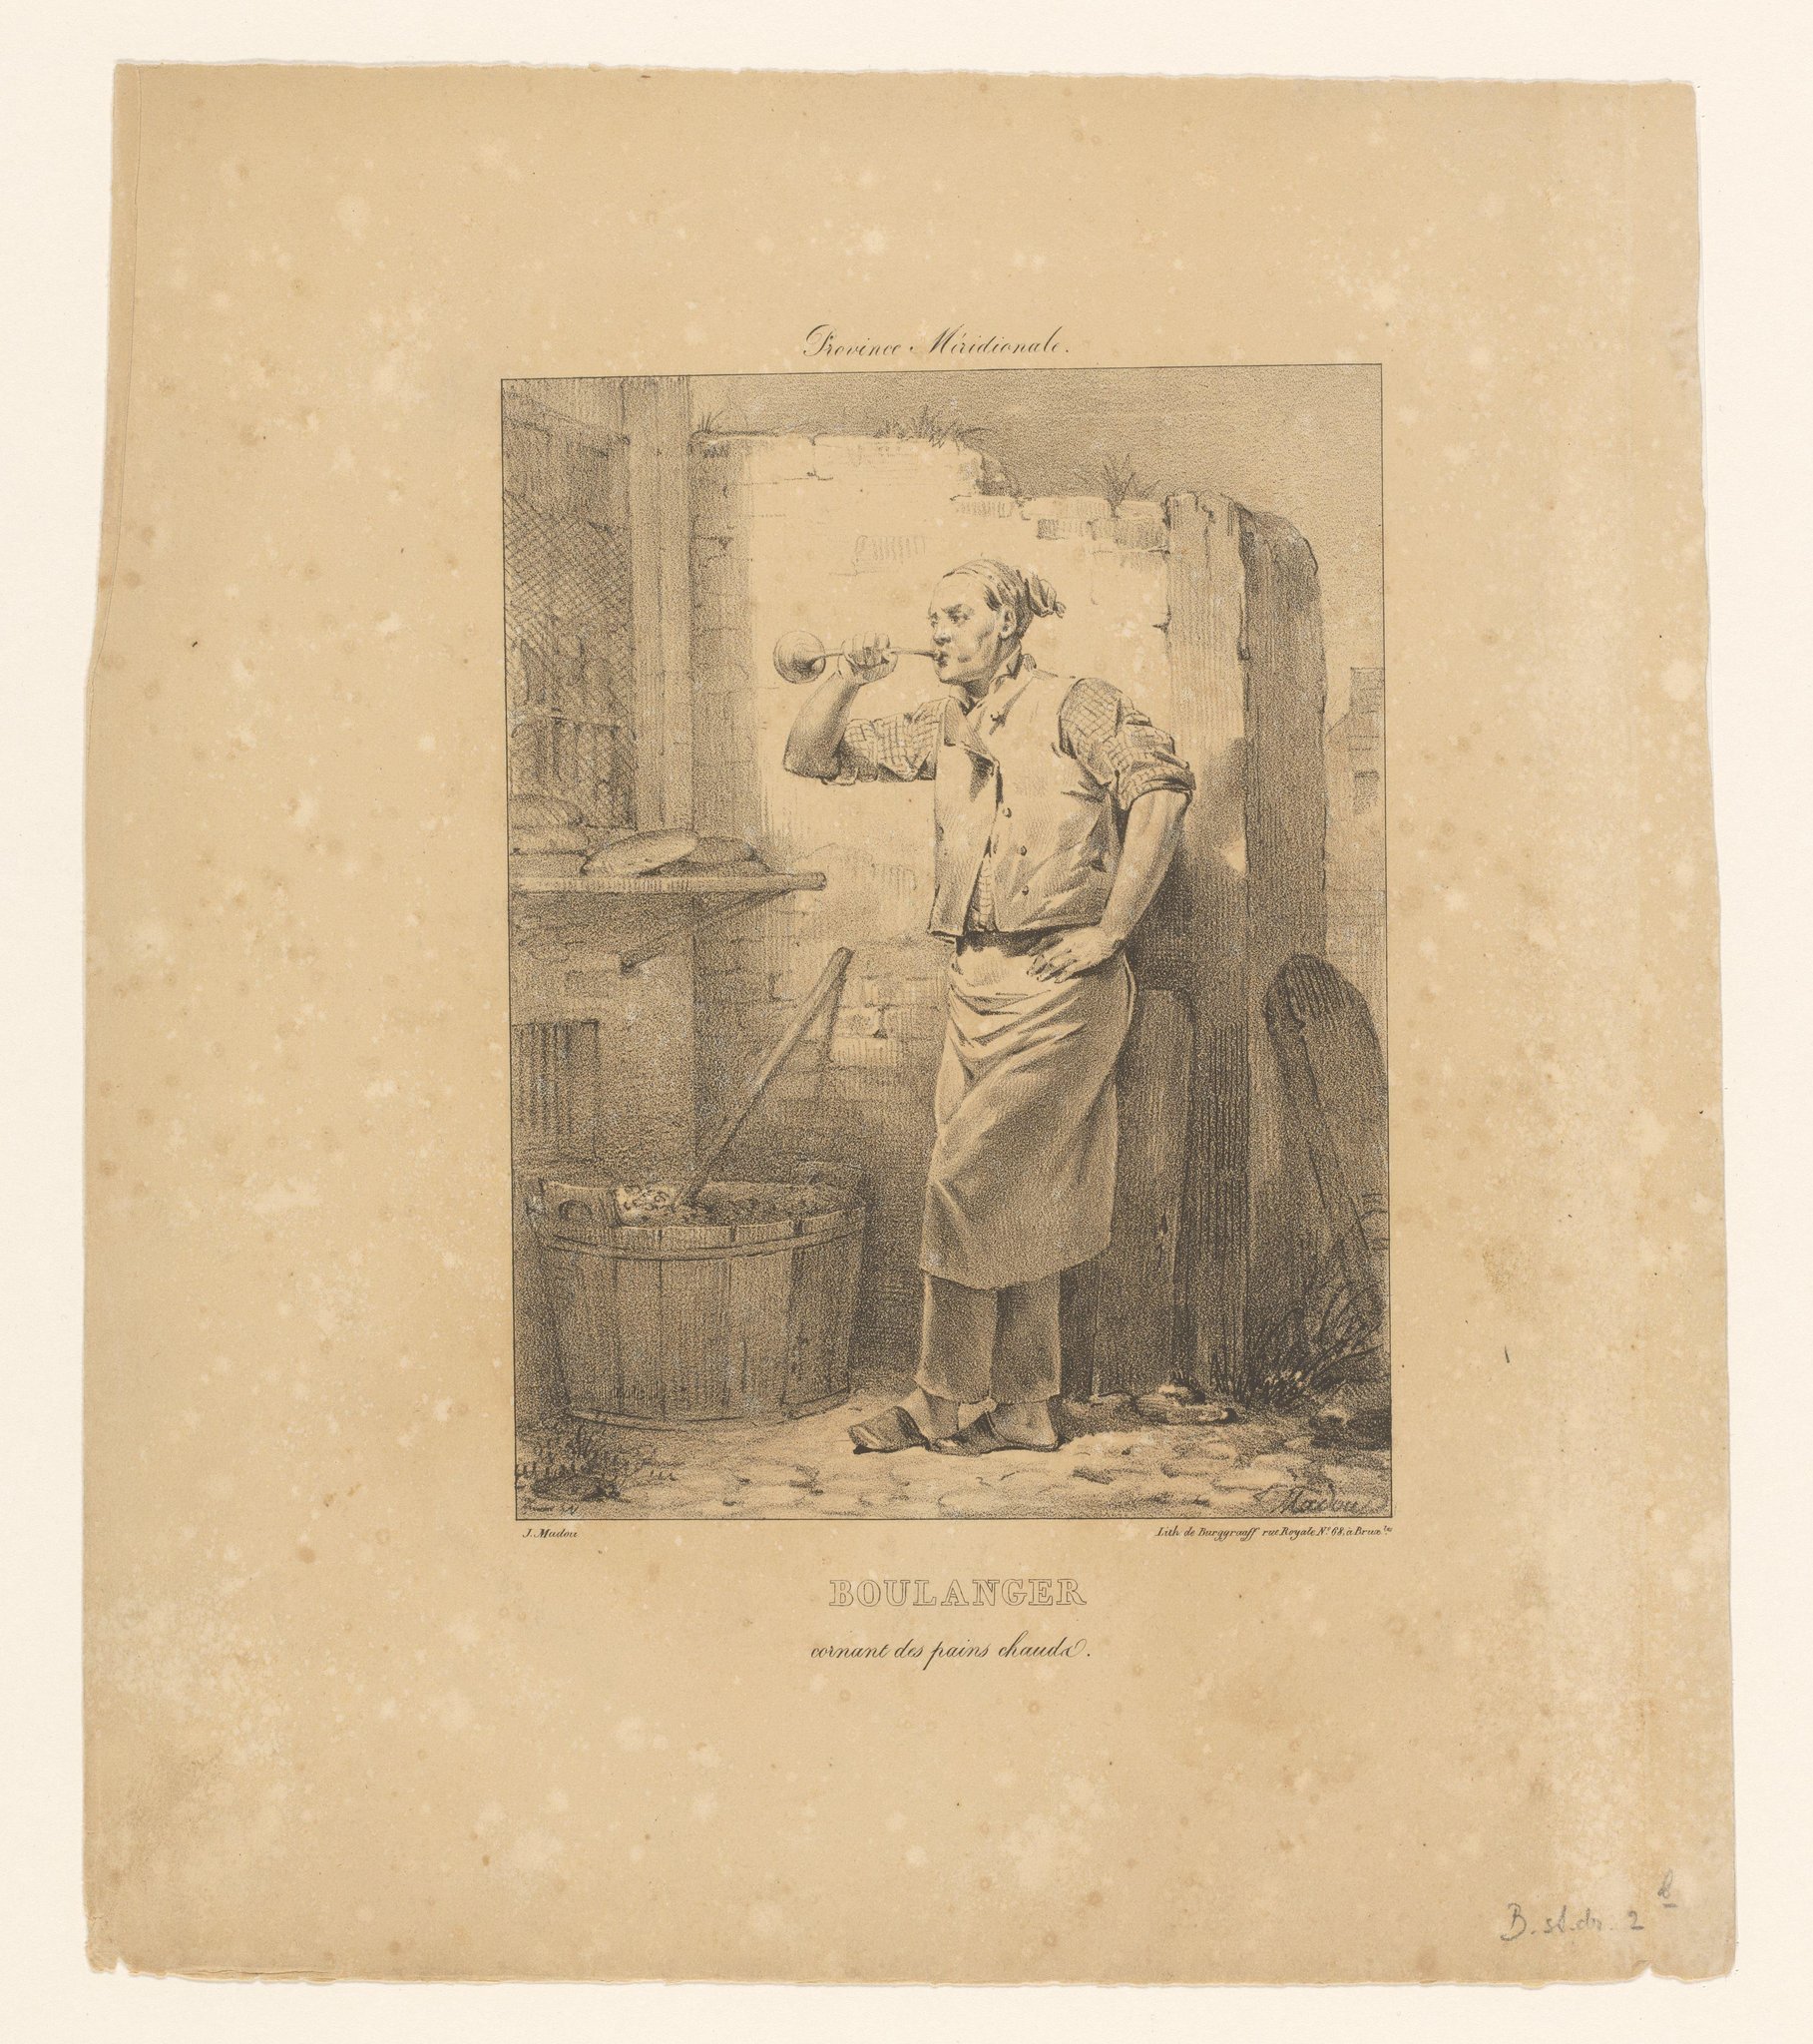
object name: print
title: Kostuums van de inwoners van België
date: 1825-1835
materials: paper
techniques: lithograph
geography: brussels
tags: baker, folk costume, regional costume, hornblowing baker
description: Van den Burggraaff wilde een serie (twintig afleveringen met telkens vier platen) uitgeven met kostuums uit alle provincies van Nederland en België onder de titel 'Costumes du peuple de toutes les provinces des Pays-Bas'. Hij begint met deze serie in 1825 en eindigt hiermee bij de dertiende aflevering in 1830. Omdat in 1830 België zicht afsplitst van Nederland geeft hij de prenten daarna apart uit onder de titels 'Costumes de peuple Hollandais' en 'Collection de costumes du peuple des provinces de la Belgique' (1835).